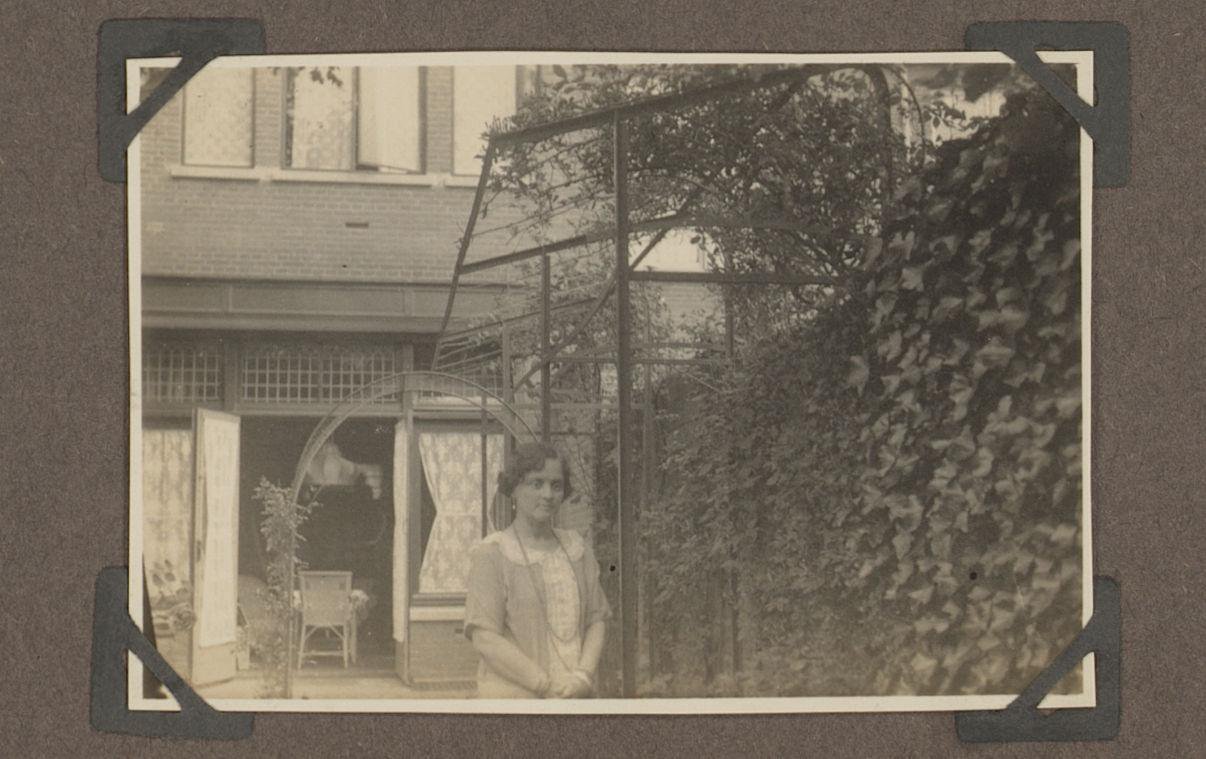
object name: album leaf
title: Henriëtte Wassink staand in tuin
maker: Anonymous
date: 1930-1935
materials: paper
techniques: gelatin silver print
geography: netherlands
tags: batavia, the hague, henriëtte wassink, adult woman, garden, netherlands